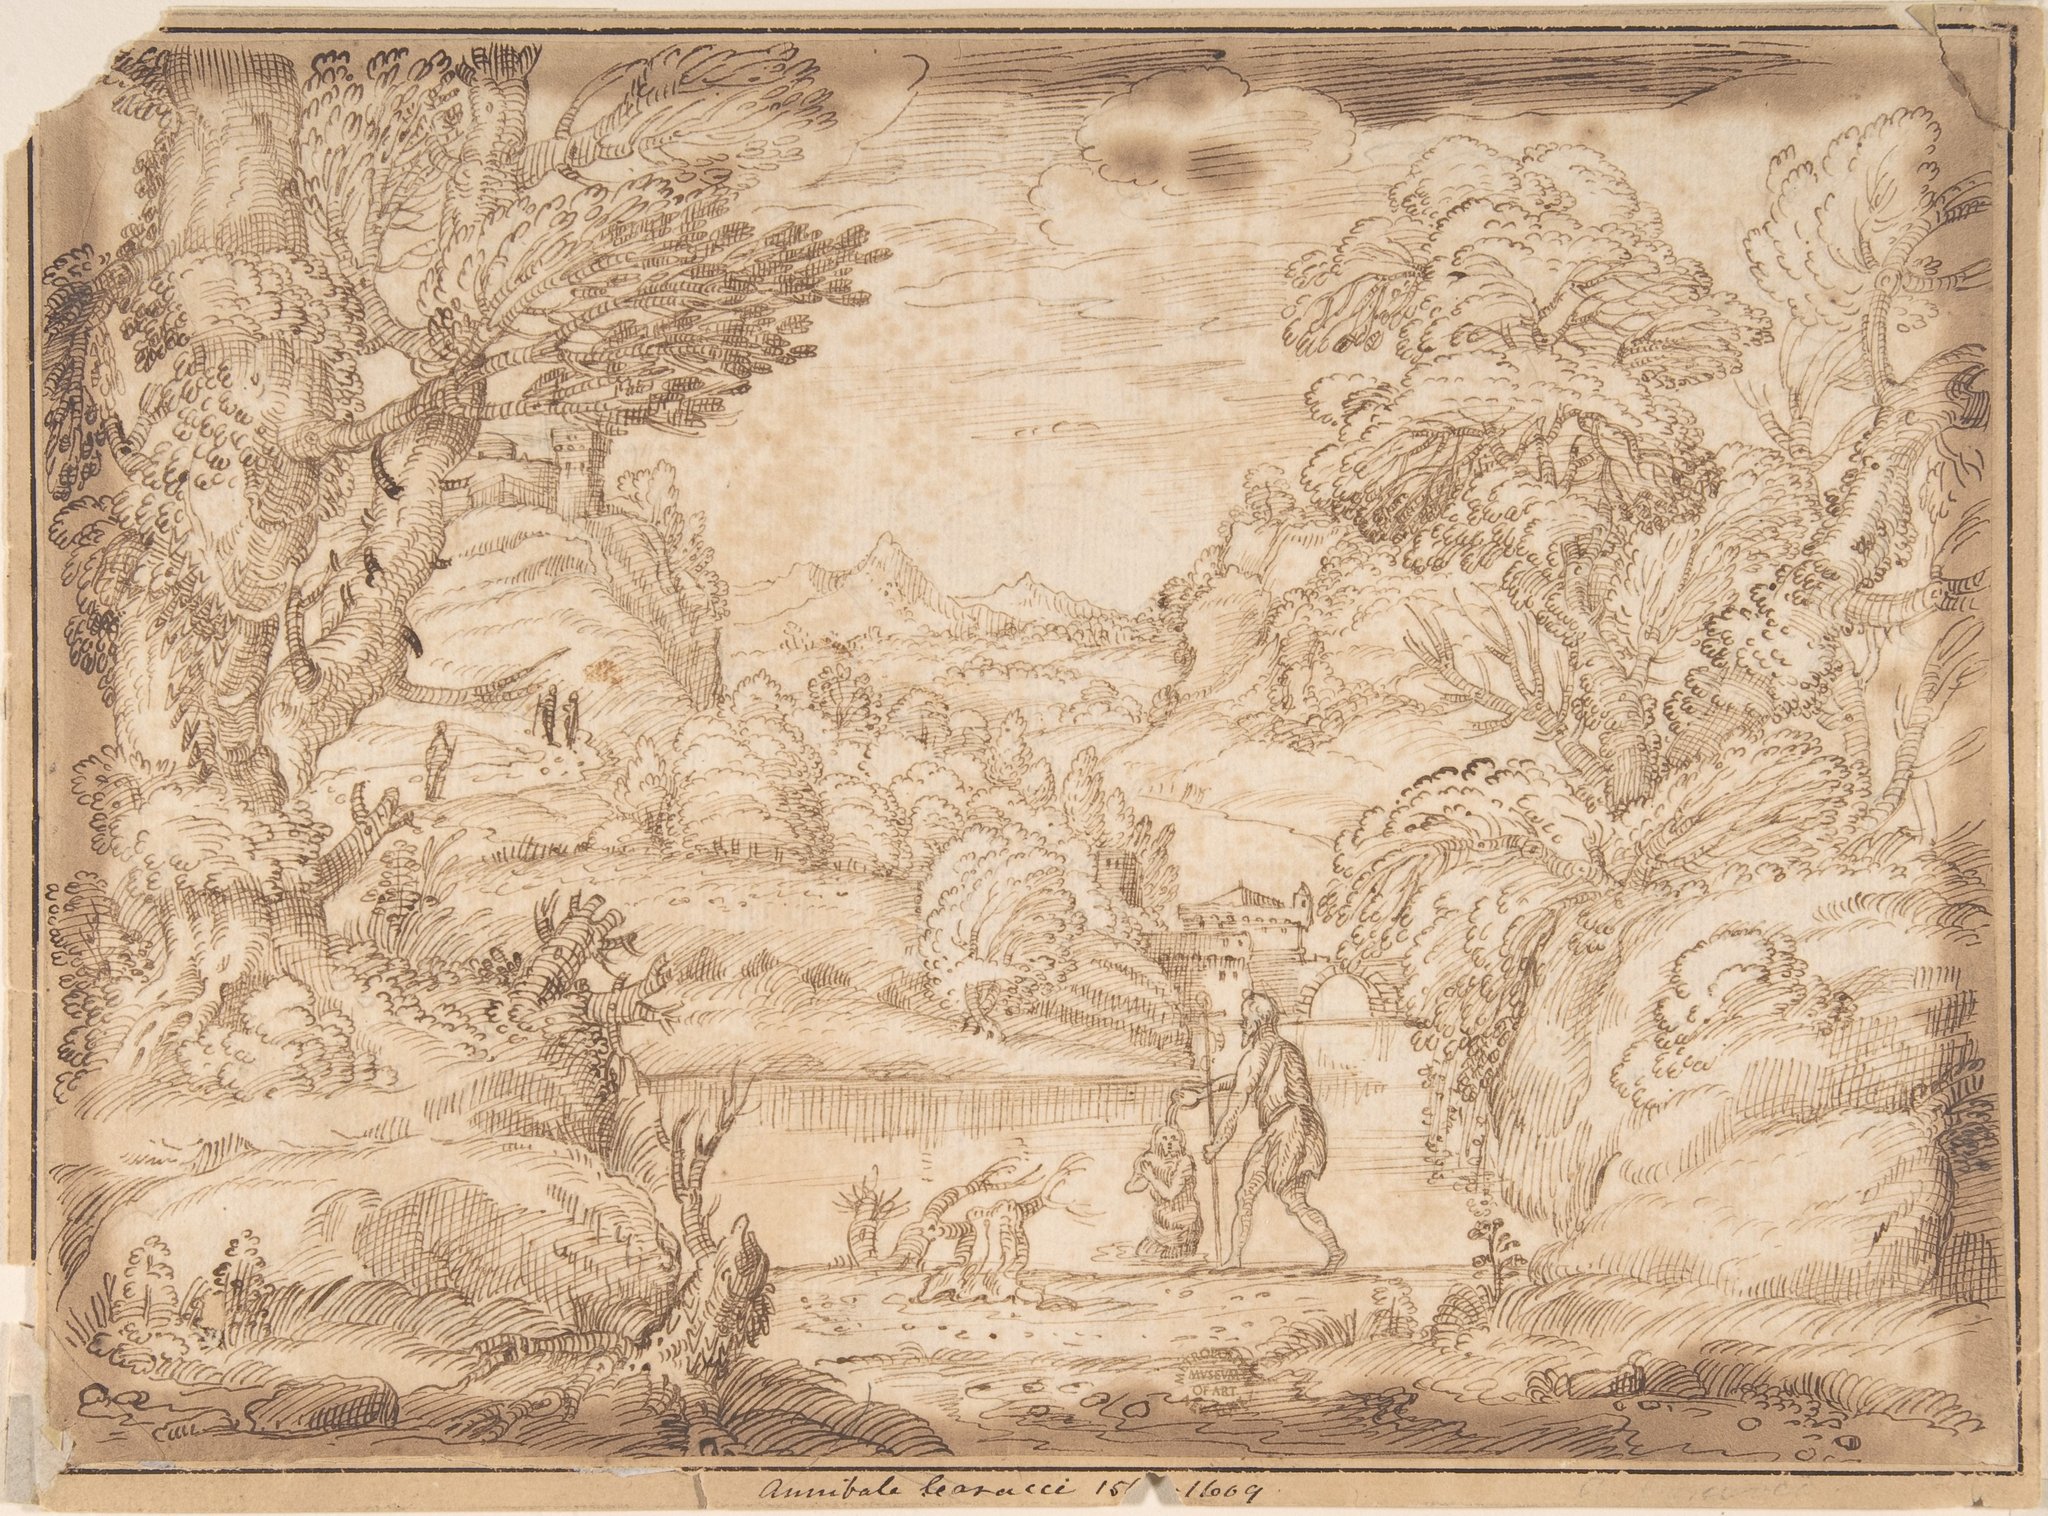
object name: drawing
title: Landscape with the Baptism of Christ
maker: anonymous, italian, bolognese, 17th century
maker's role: artist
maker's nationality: italian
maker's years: 1600-1700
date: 1601-1700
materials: chalk, ink, paper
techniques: pen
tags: landscapes,trees,baptism of christ